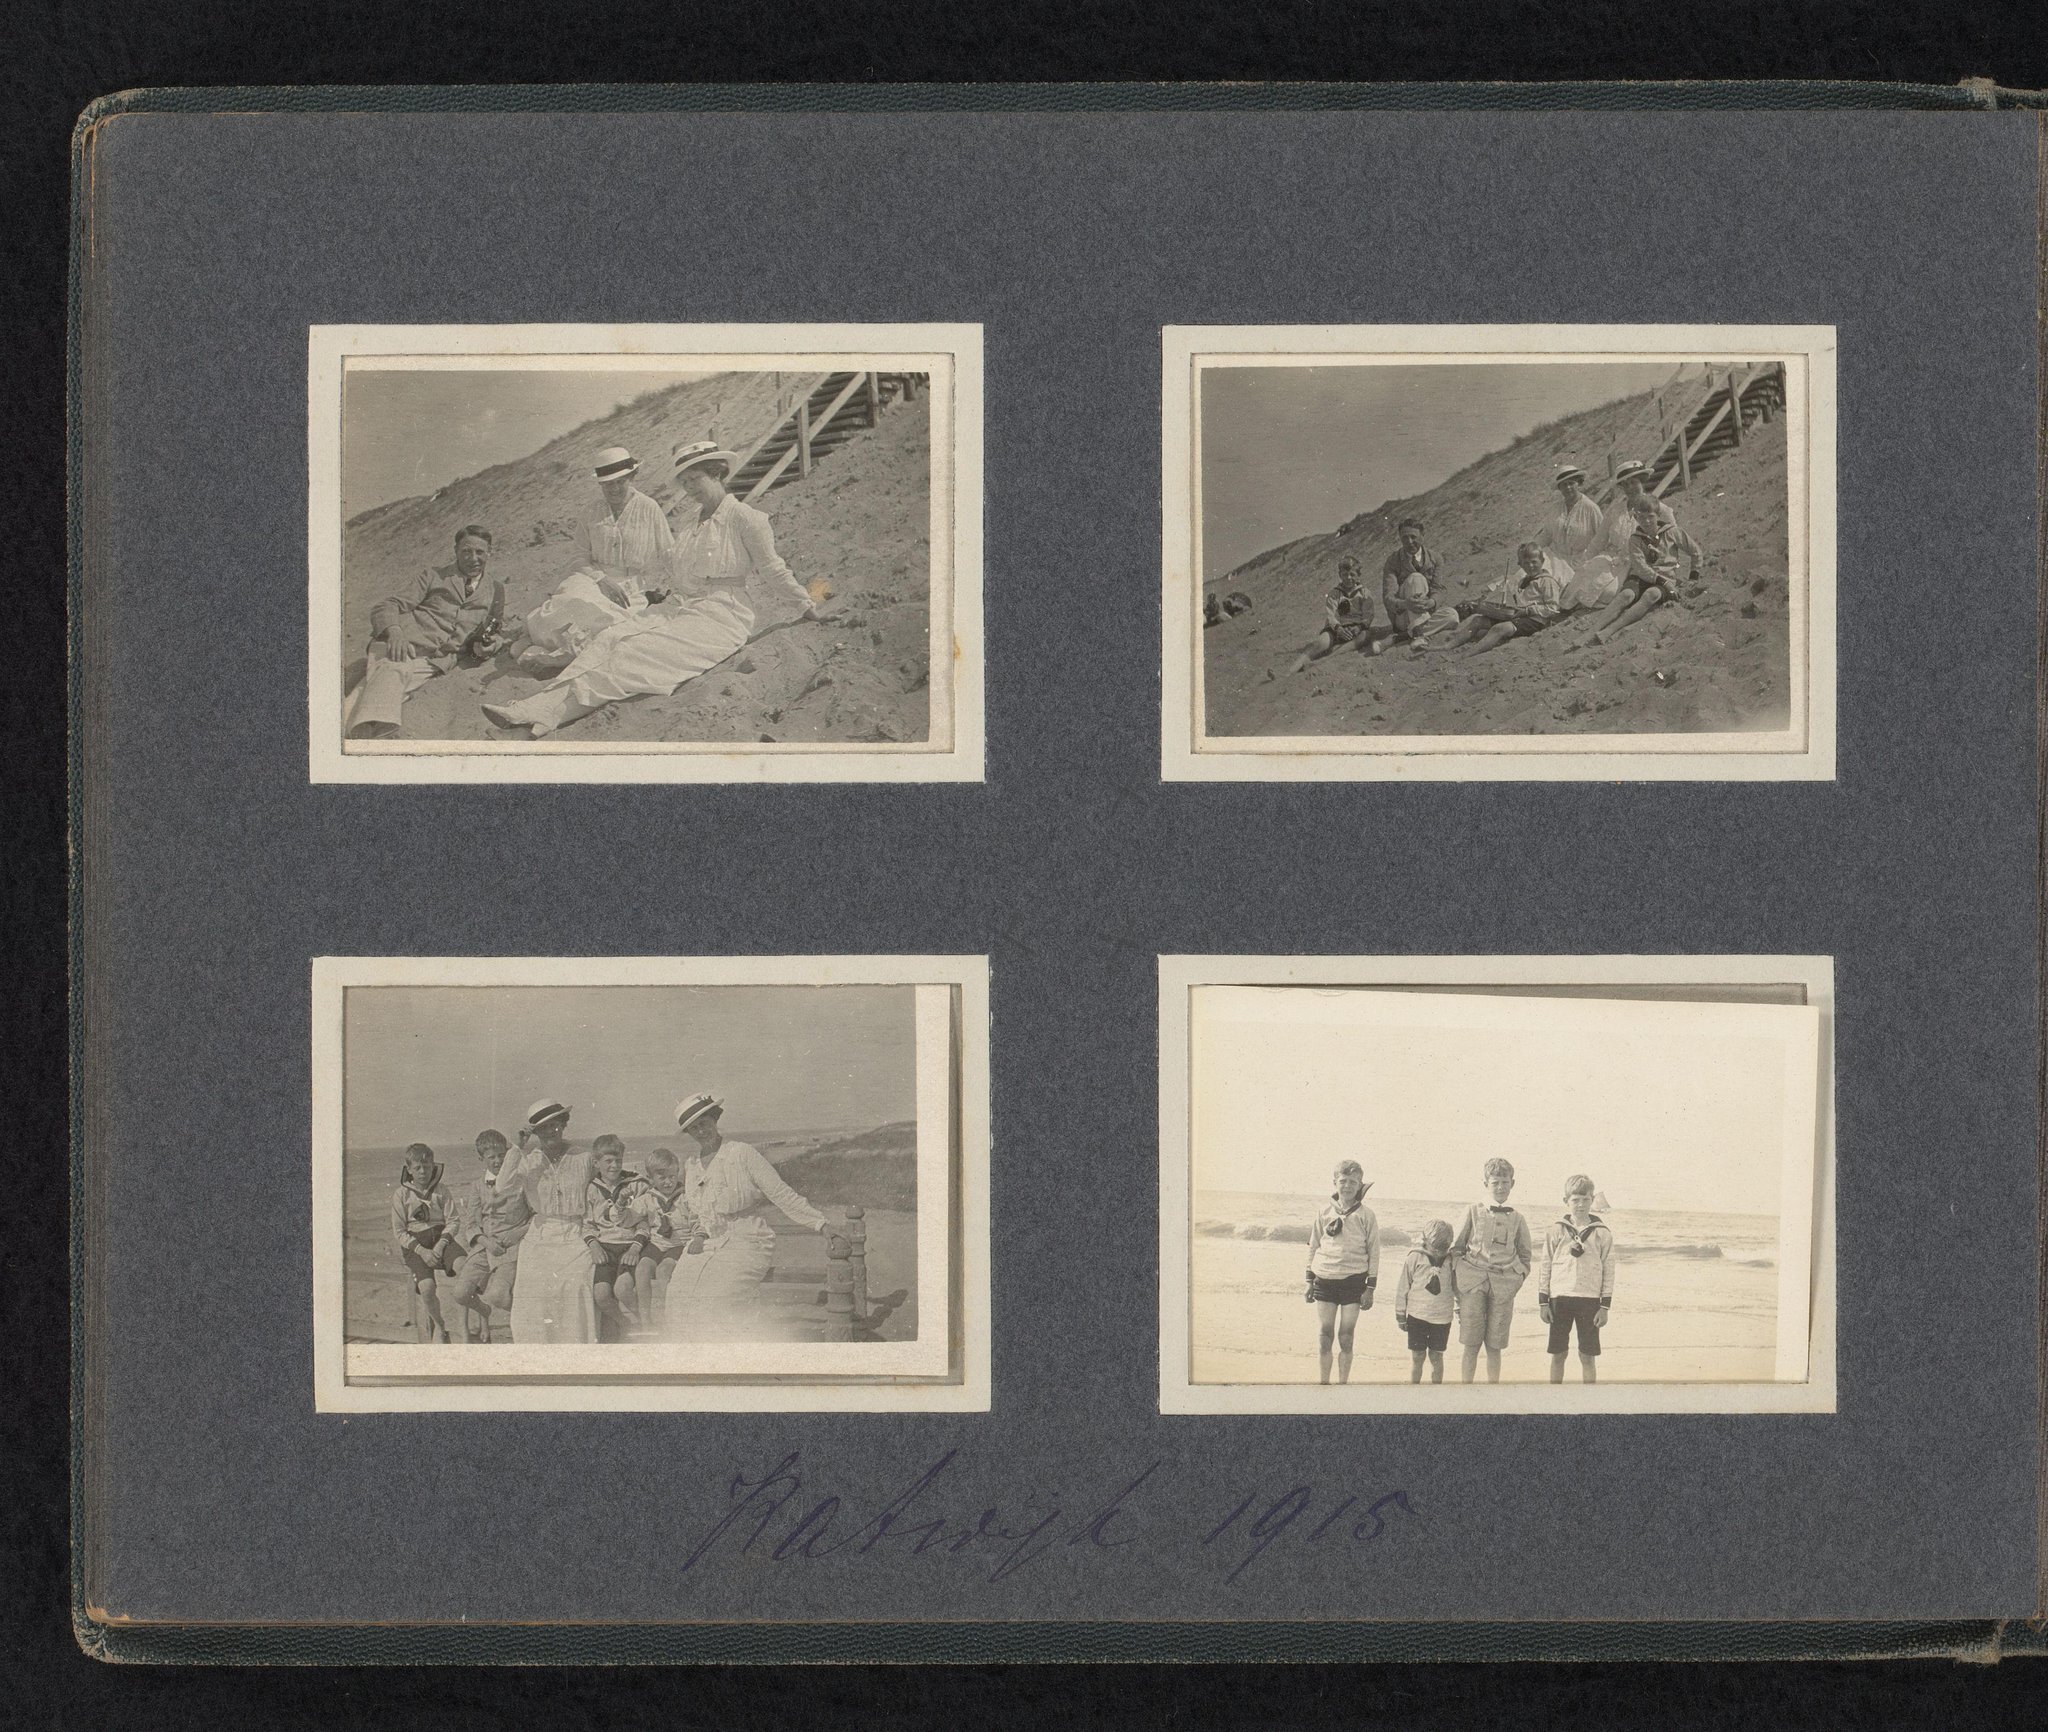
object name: album leaf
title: Familie van den Berg op het strand in Katwijk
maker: hendrik herman van den berg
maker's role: amateurfotograaf, jurist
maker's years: 1875-1944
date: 1915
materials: paper, cardboard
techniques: gelatin silver print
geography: katwijk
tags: beach (as place of recreation)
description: Deze foto's zijn onderdeel van een album.